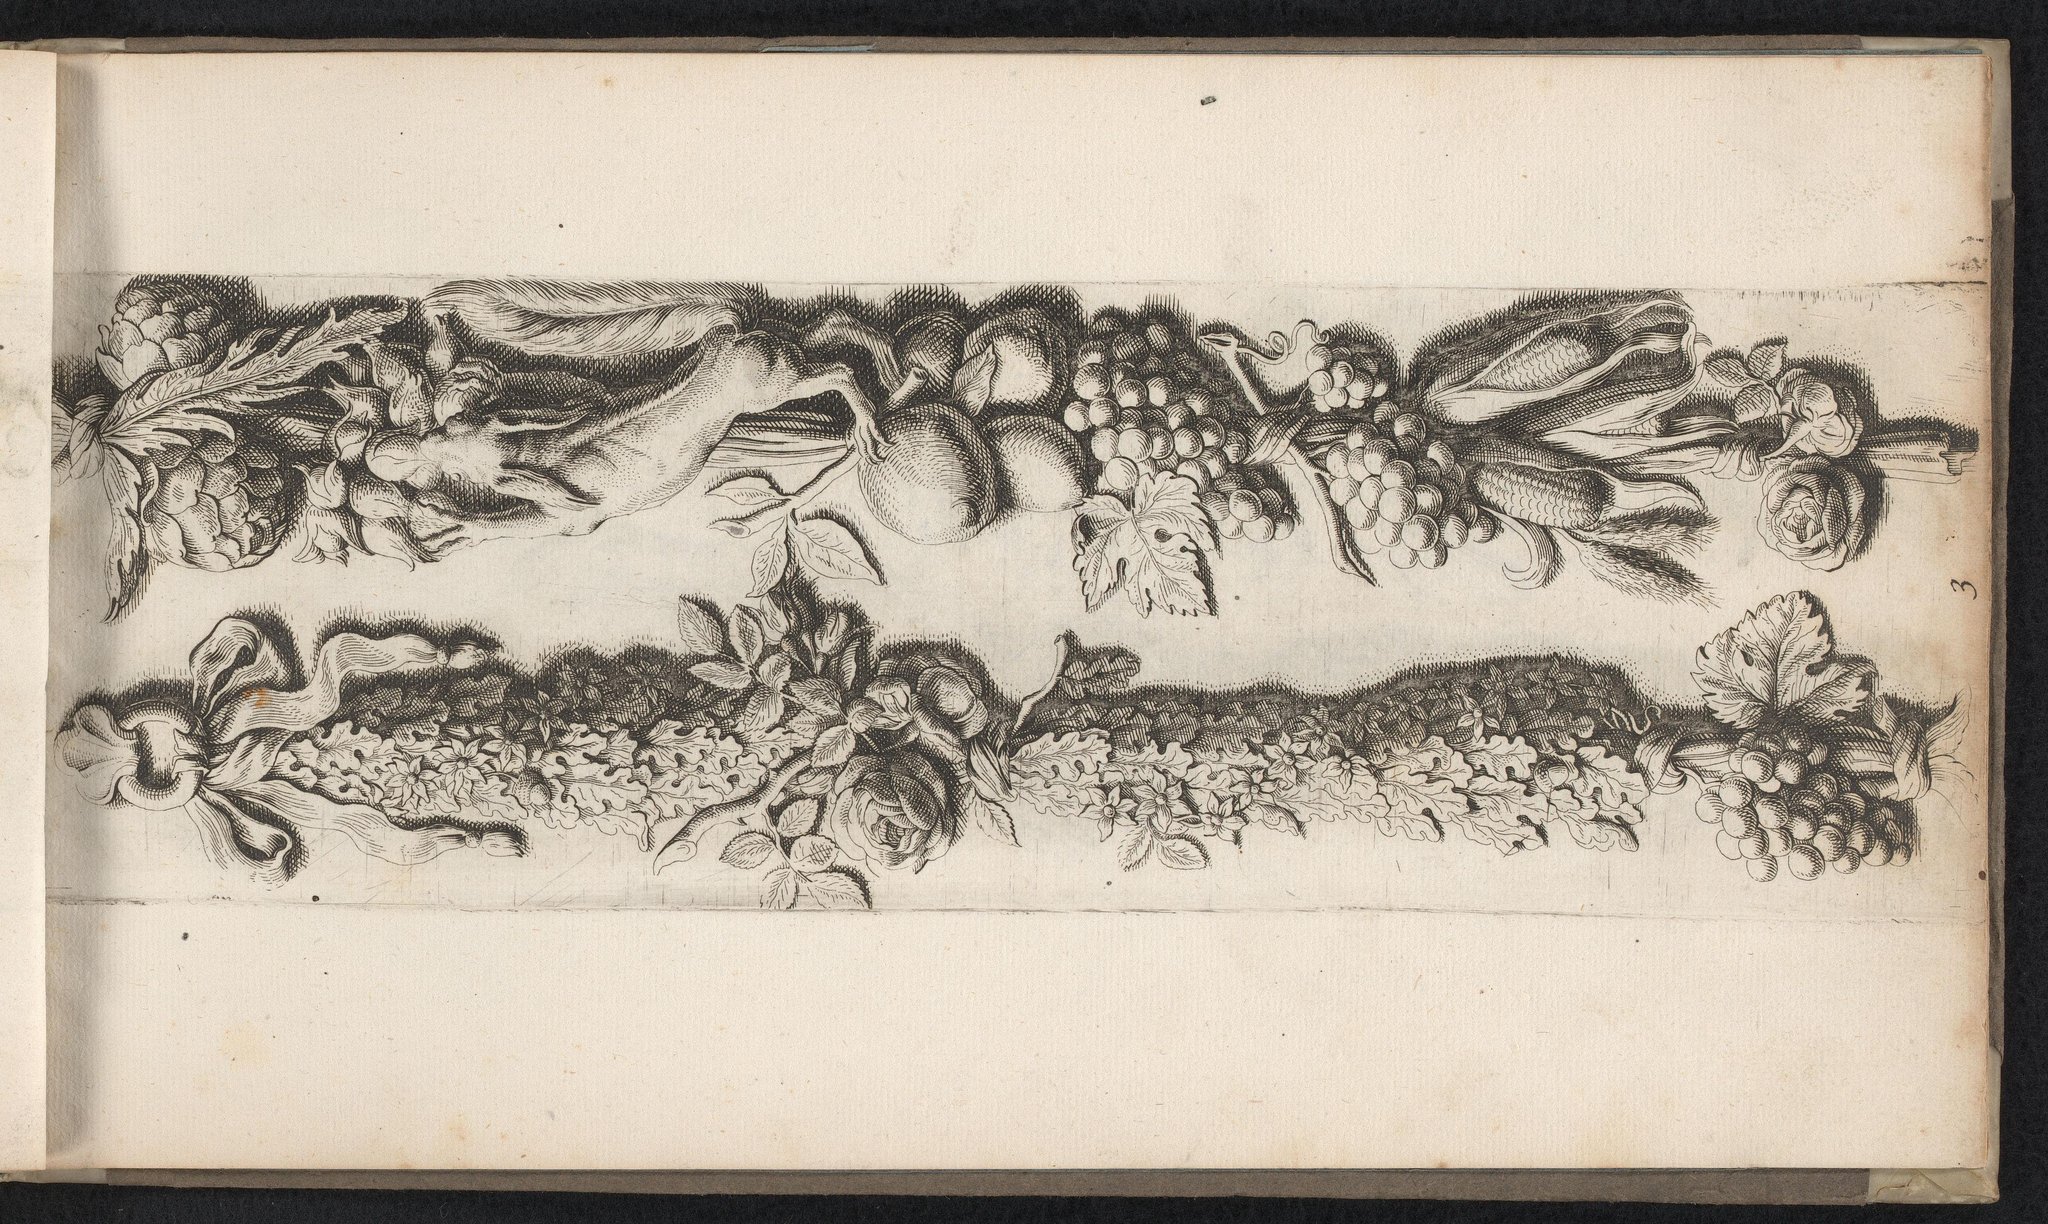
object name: ornament print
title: Pilasterfestoenen met een eekhoorn en hazelnoten uit het stadhuis van Amsterdam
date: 1665-1685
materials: ink, paper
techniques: etching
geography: amsterdam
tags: ornament ~ festoon, garland, rodents: squirrel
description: Een prent van vijf genummerde prenten met festoenen met titelpagina. Kopieën in spiegelbeeld naar de prenten in Artus Quellinus, Prima Pars Praecipuarium(…), Amsterdam 1665. Gebonden in 19de-eeuwse band met blauwe kaft en witte rug, genummerd: 3.